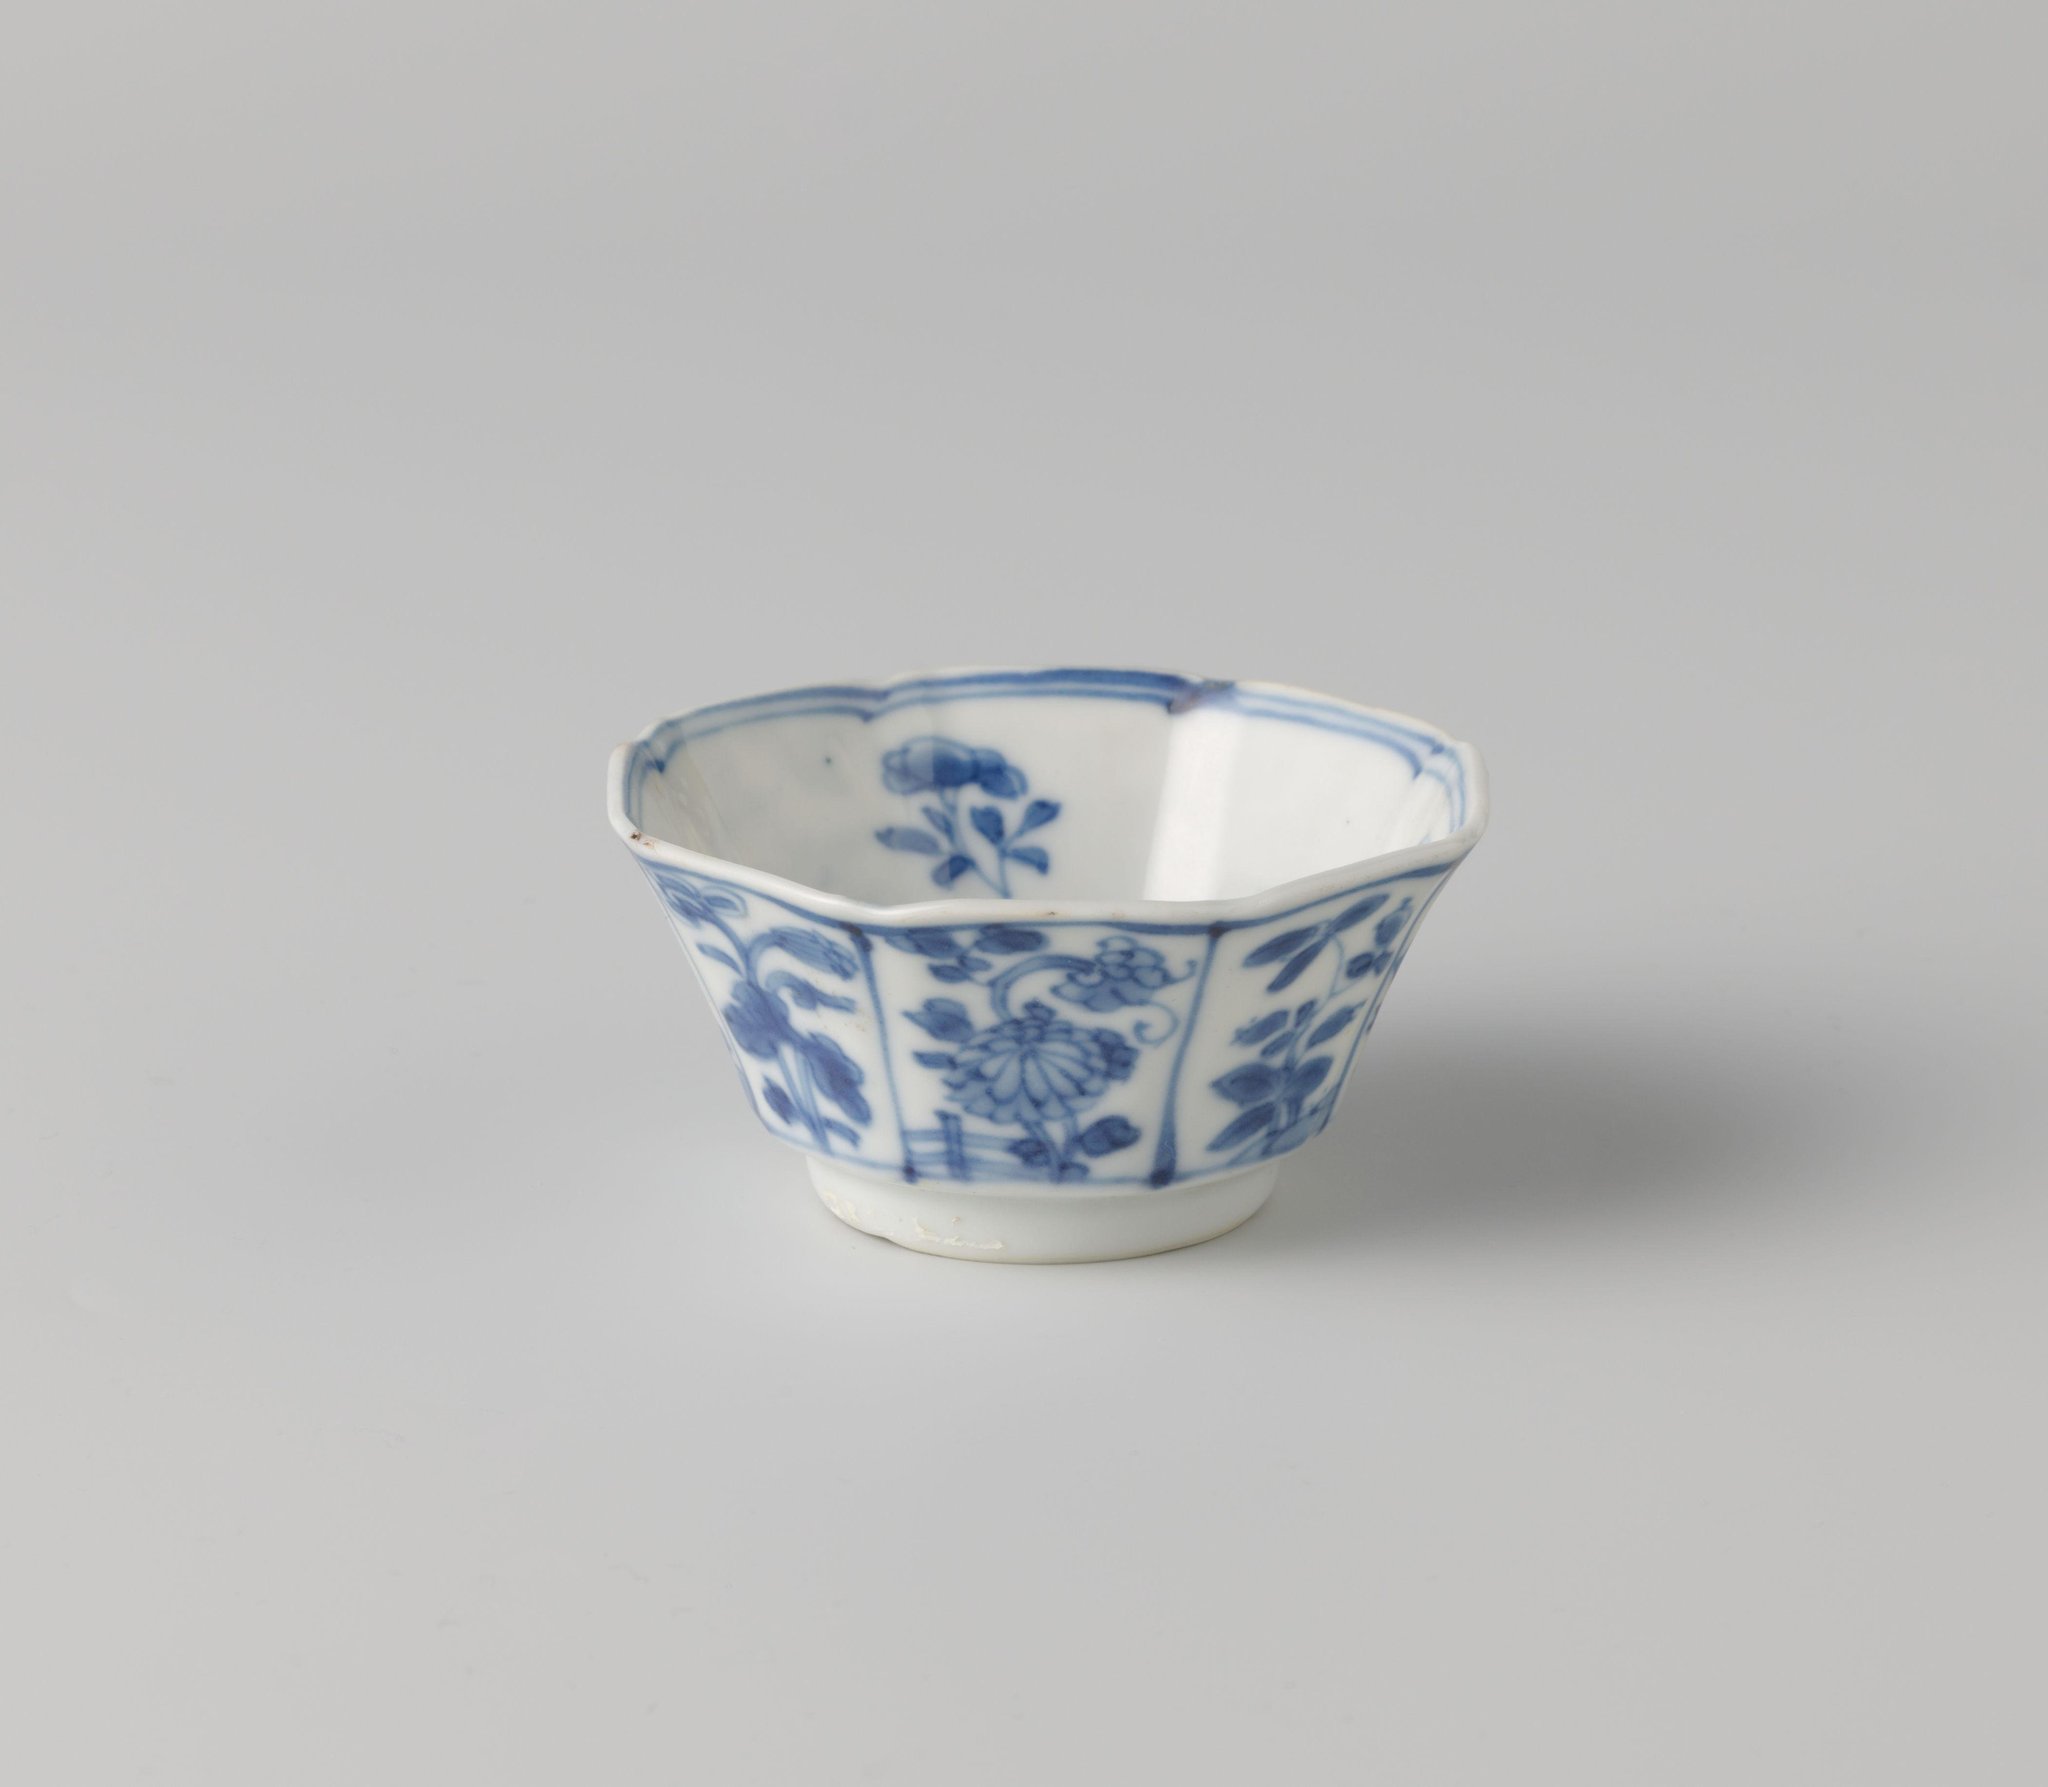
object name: cup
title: Octagonal cup with panel decoration with flower sprays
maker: Anonymous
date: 1680-1720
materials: cobalt, glaze, paint, porcelain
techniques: firing, forming, turning, vitrification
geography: china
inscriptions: mark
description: Achtkantige schotel, gedecoreerd in ondergalzuur blauw. Im het centrum een rozet, acht velden met bloeiende planten daar omheen.